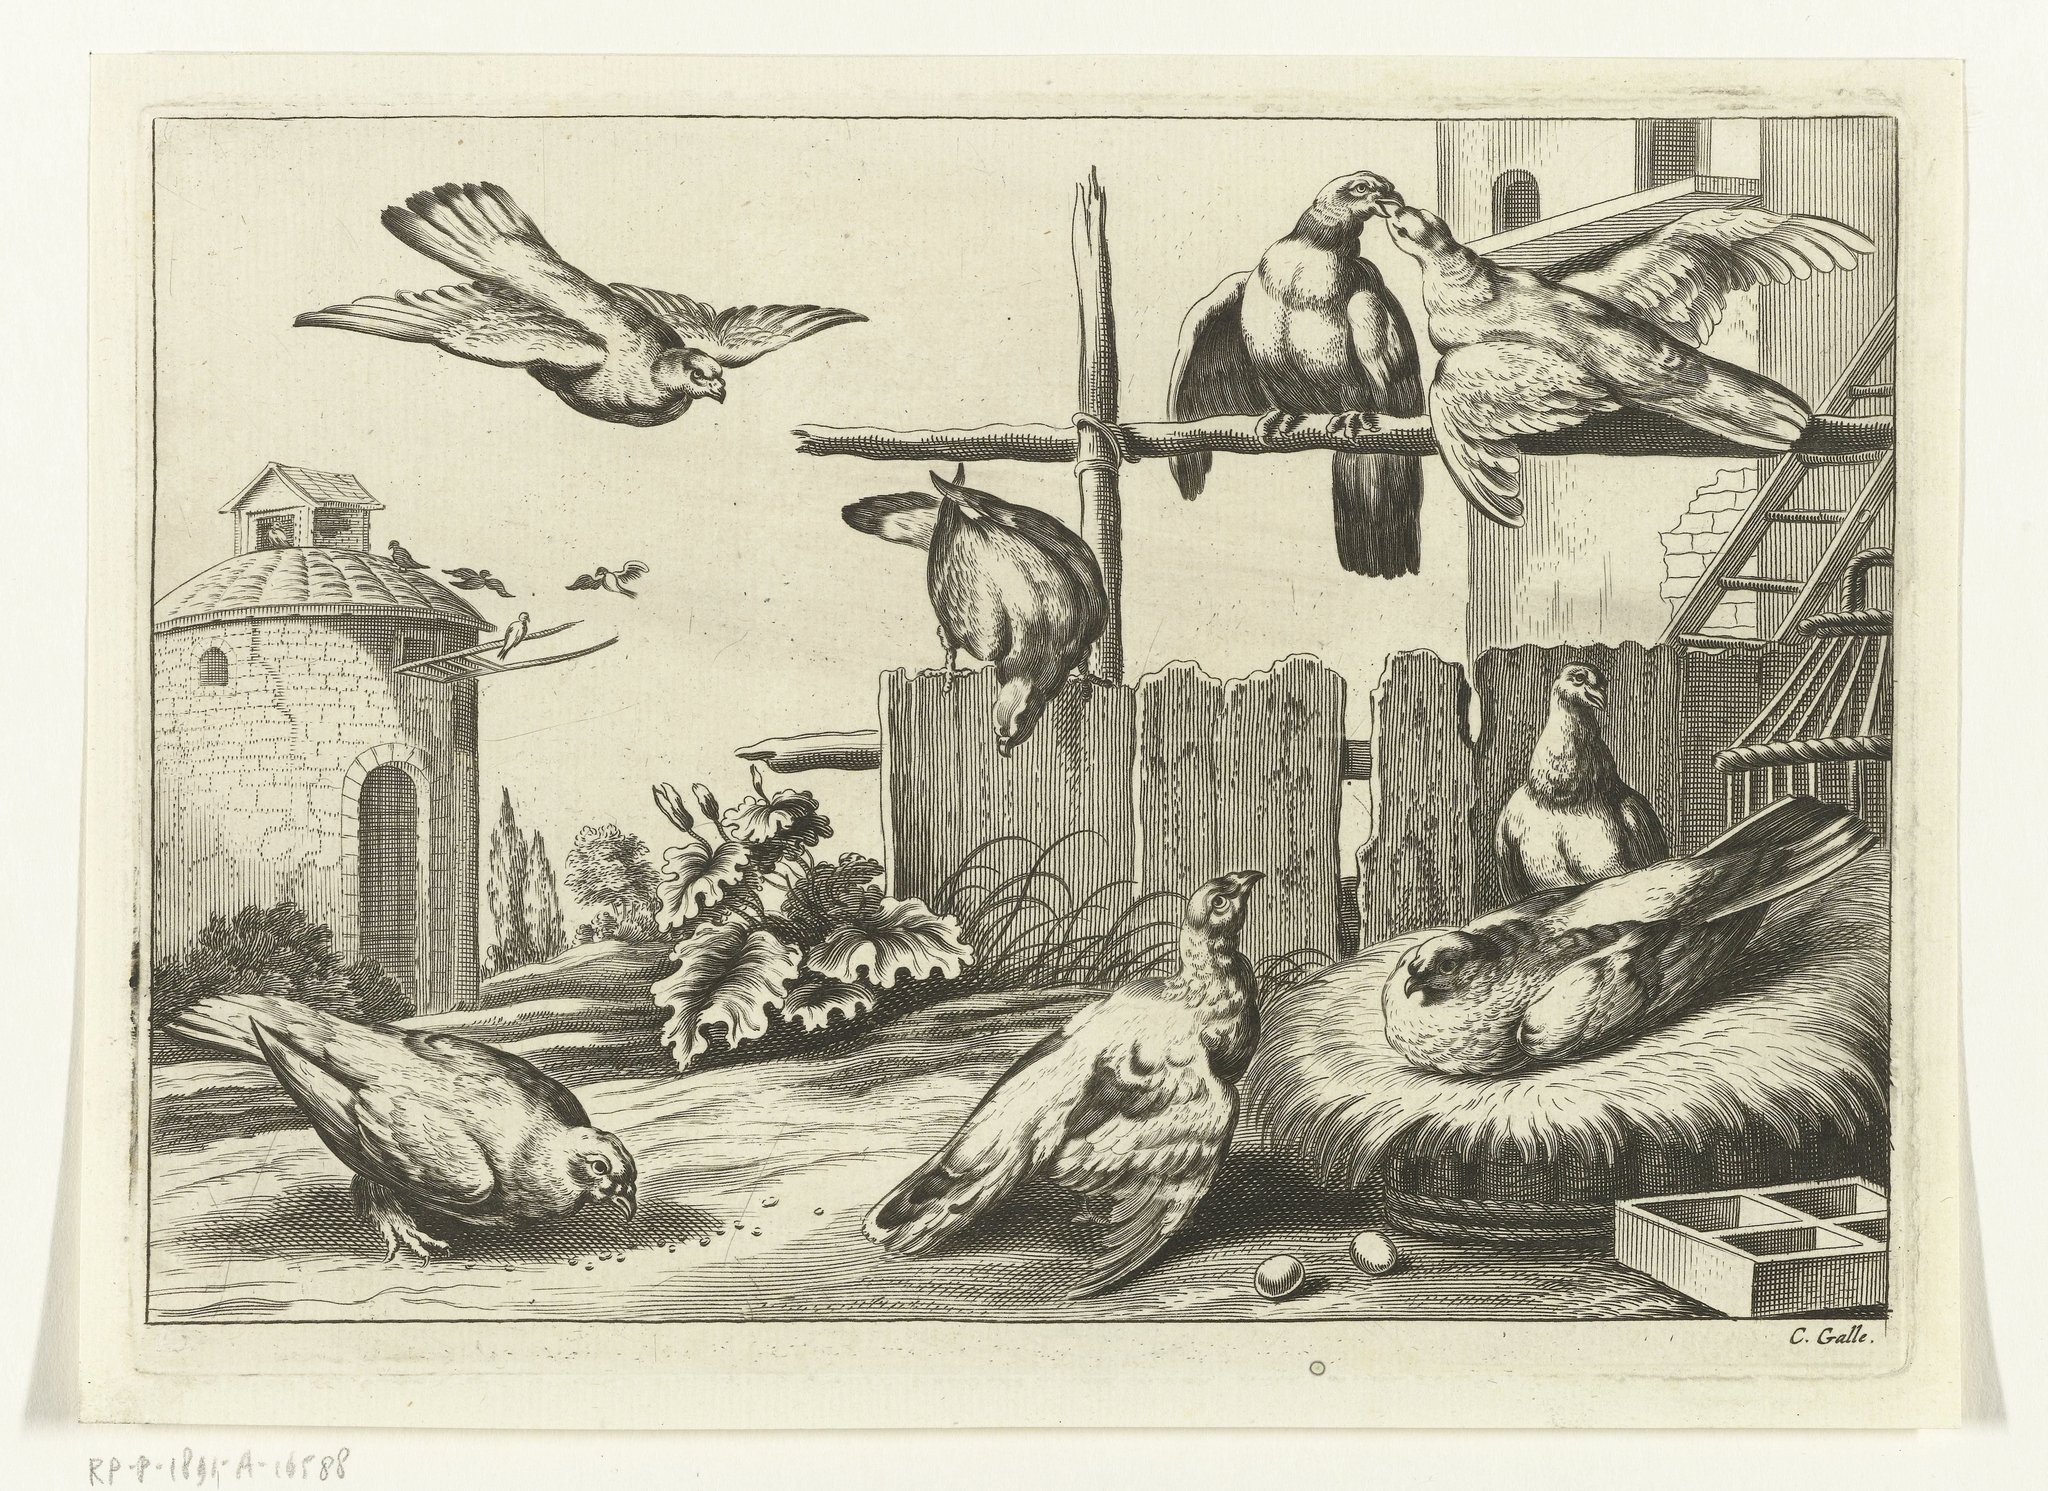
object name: print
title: Diversarum avium species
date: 1654-1678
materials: paper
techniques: engraving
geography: antwerp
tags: dove-cote, doves, pigeons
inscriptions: collector's mark: Lugt 2228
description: Prent maakt deel uit van de zeventiendelige serie met voorstellingen van verschillende vogels: "Diversarum avium species".